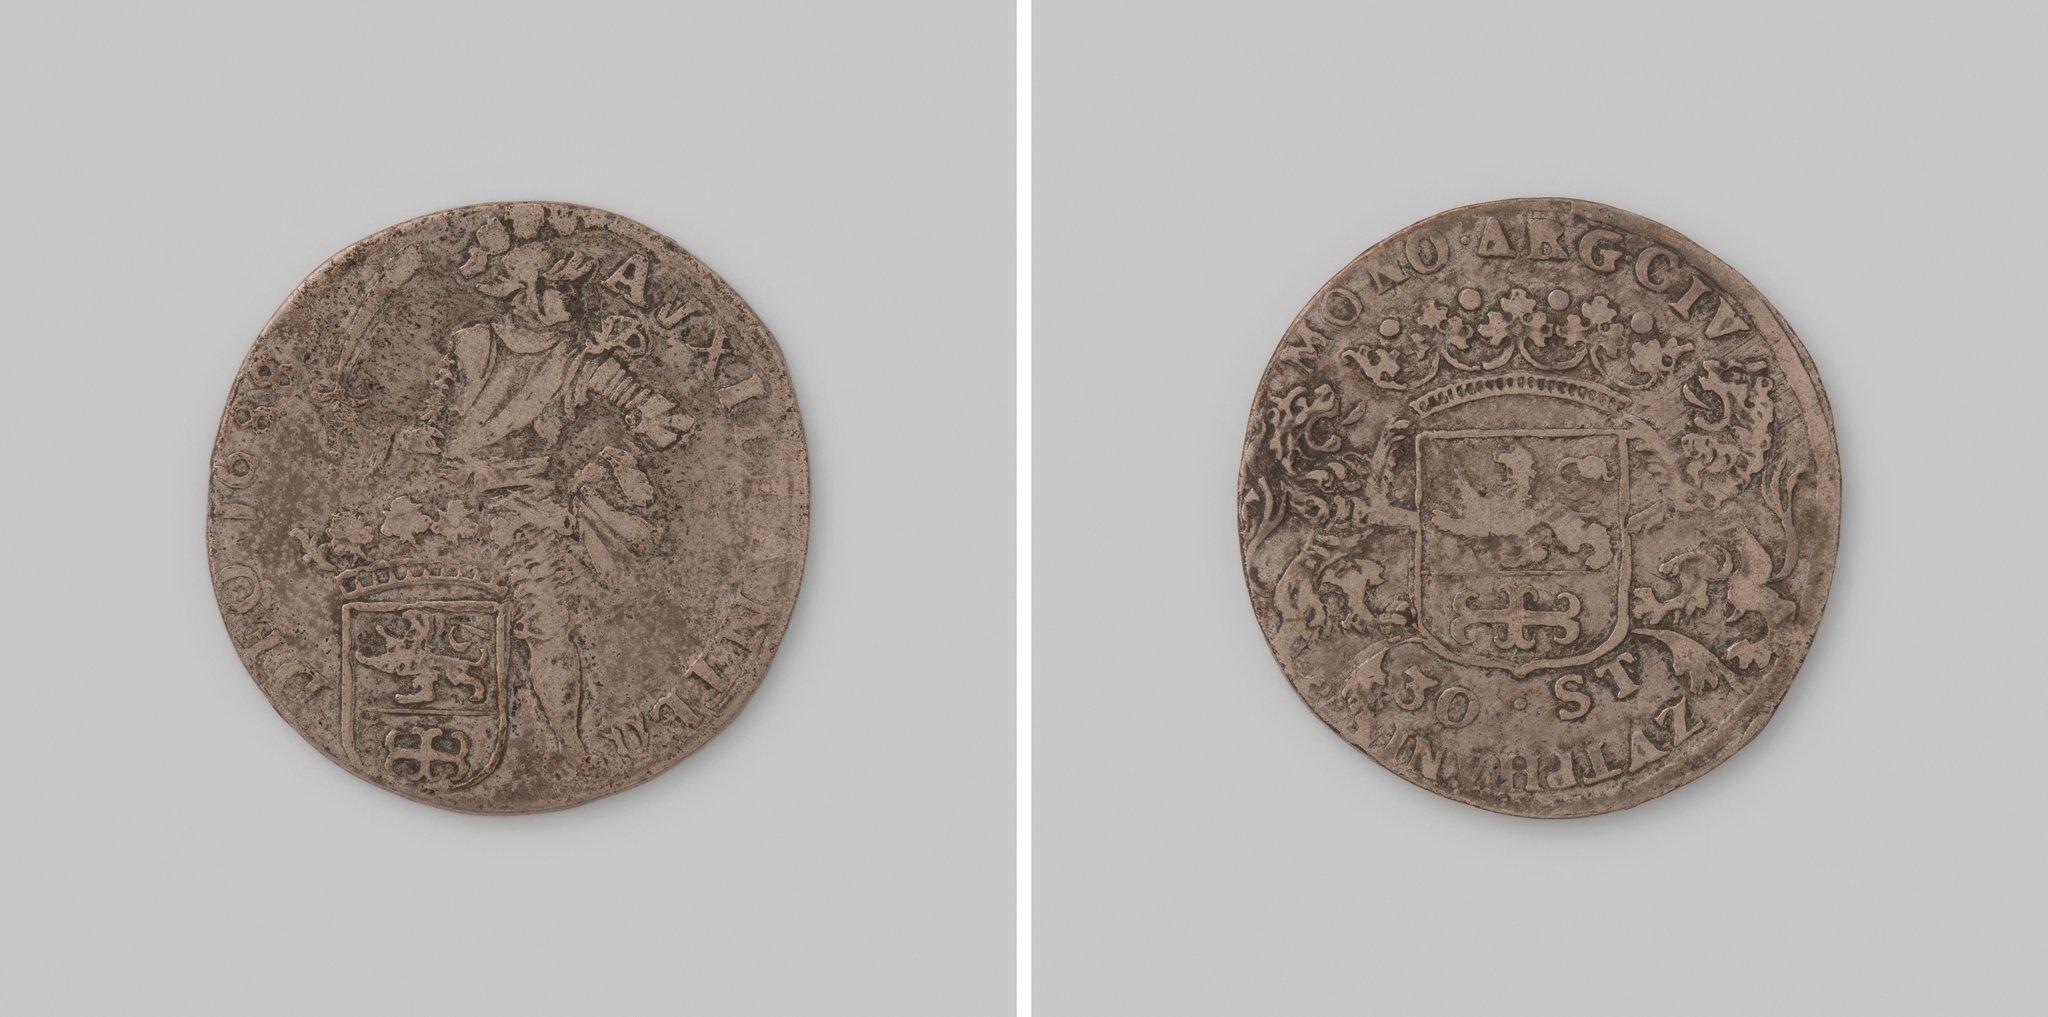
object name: coin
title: Zutphen, daalder, 1688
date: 1688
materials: silver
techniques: striking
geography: zutphen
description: Zilveren munt. Voorzijde: staande geharnaste ridder met geheven zwaard in rechterhand en gekroond wapenschild van Zutphen voor zich. Keerzijde: gekroond wapenschild van Zutphen, gehouden door twee leeuwen. Onder wapenschild waarde-aanduiding 30 ST.